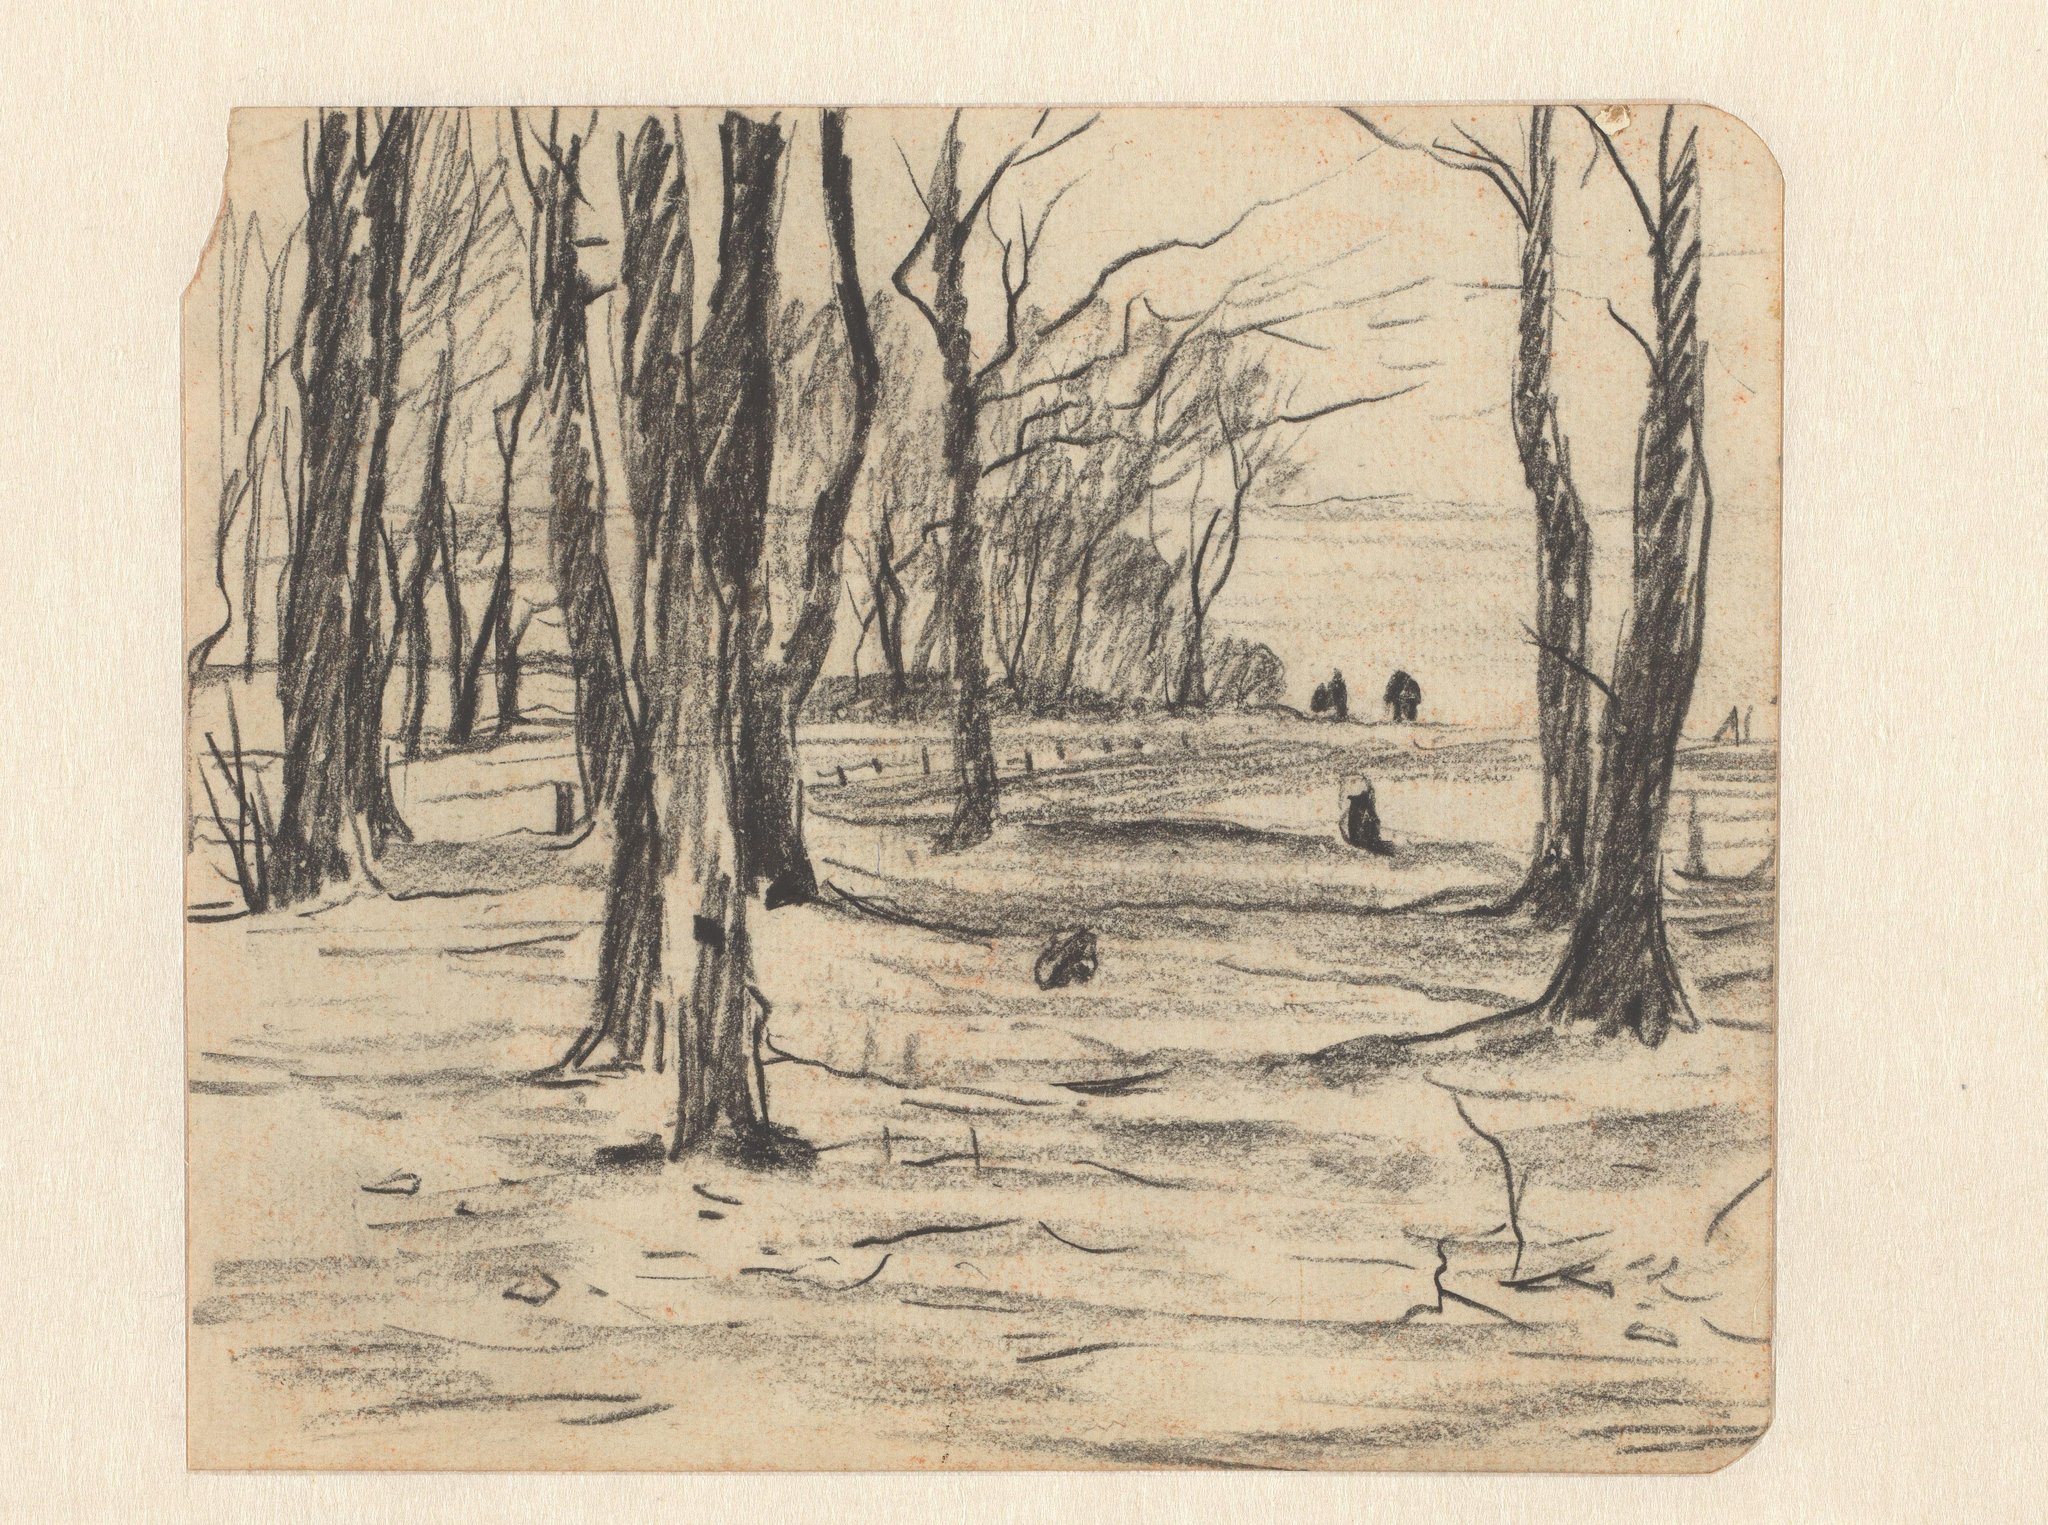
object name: drawing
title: Bomen in winterlandschap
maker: willem witsen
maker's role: draughtsman, painter, print maker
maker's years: 1860-1923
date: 1870-1923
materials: chalk, paper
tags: trees